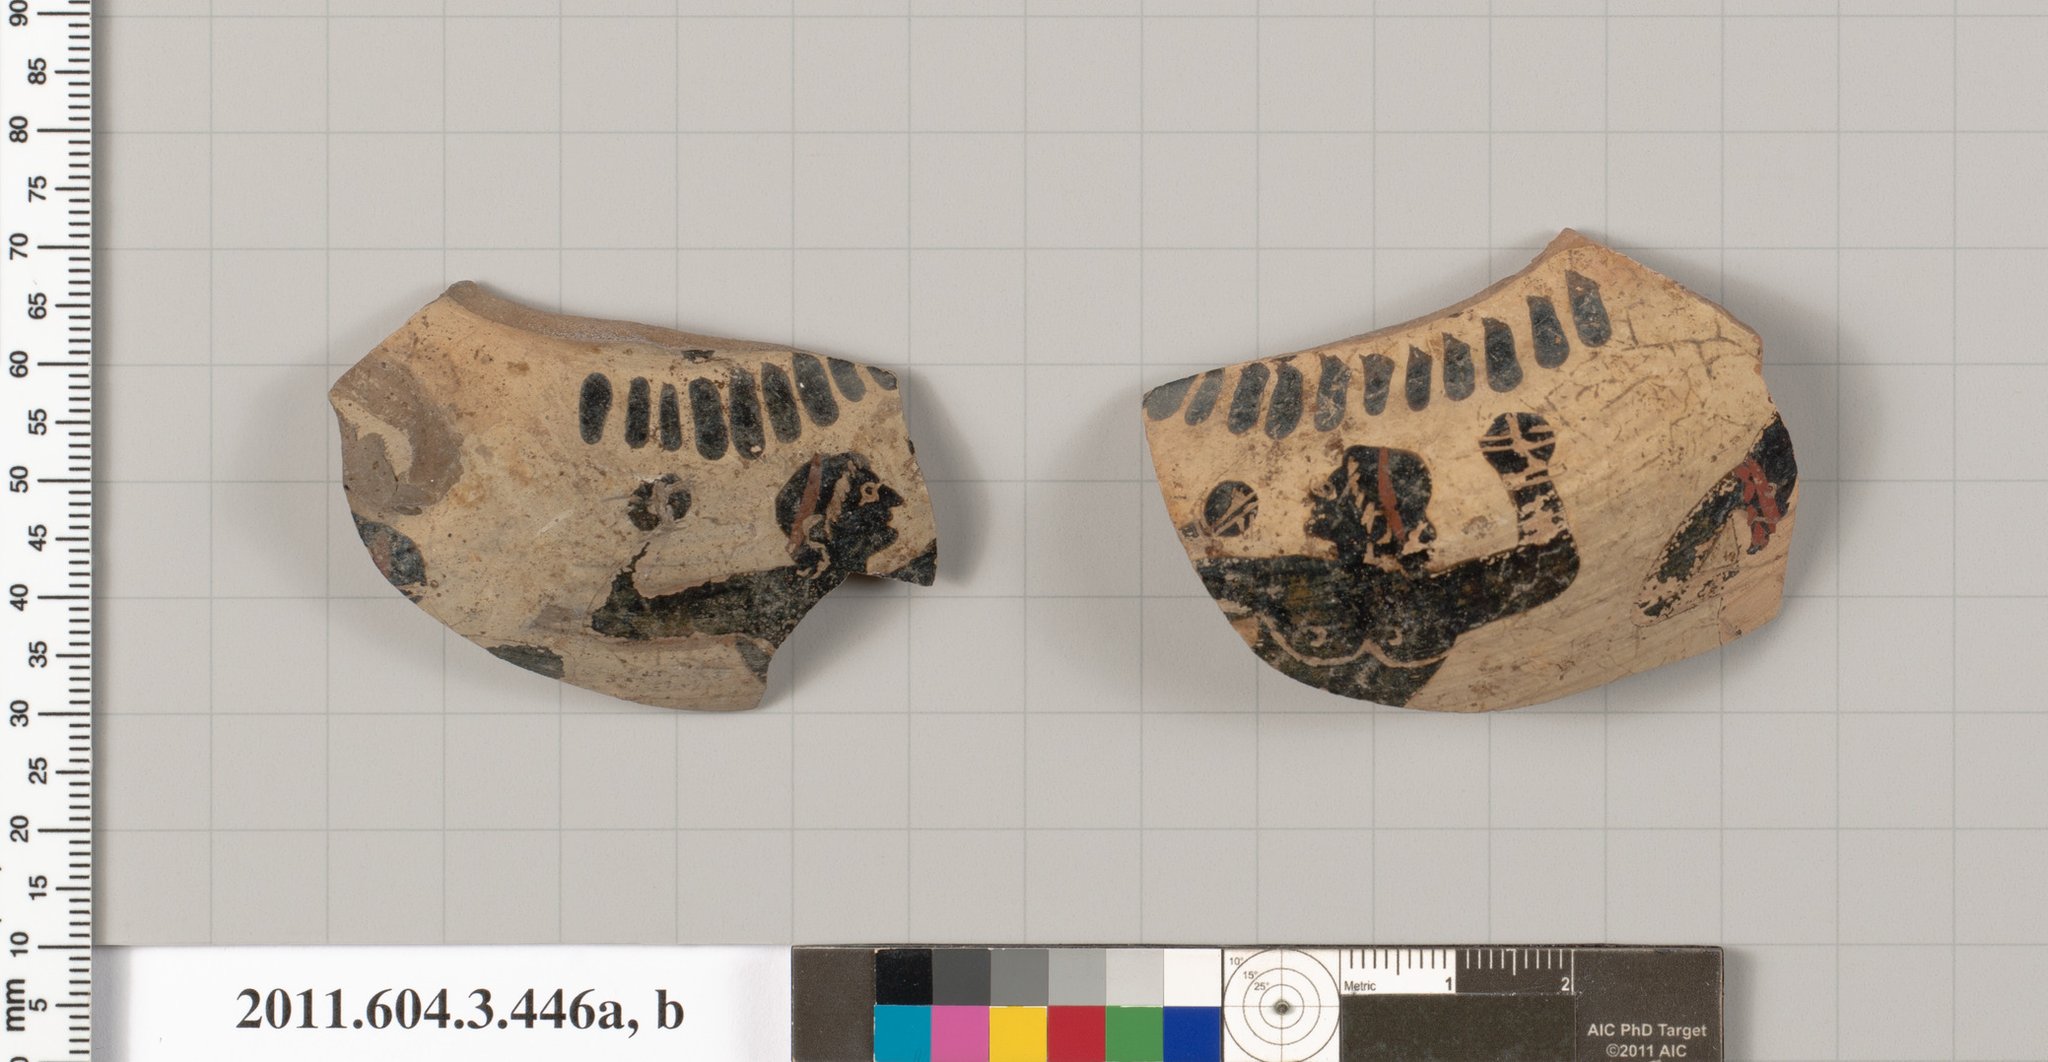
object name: neck amphora fragment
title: Terracotta fragments of a neck-amphora (jar)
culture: greek, attic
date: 490-480 BCE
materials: terracotta